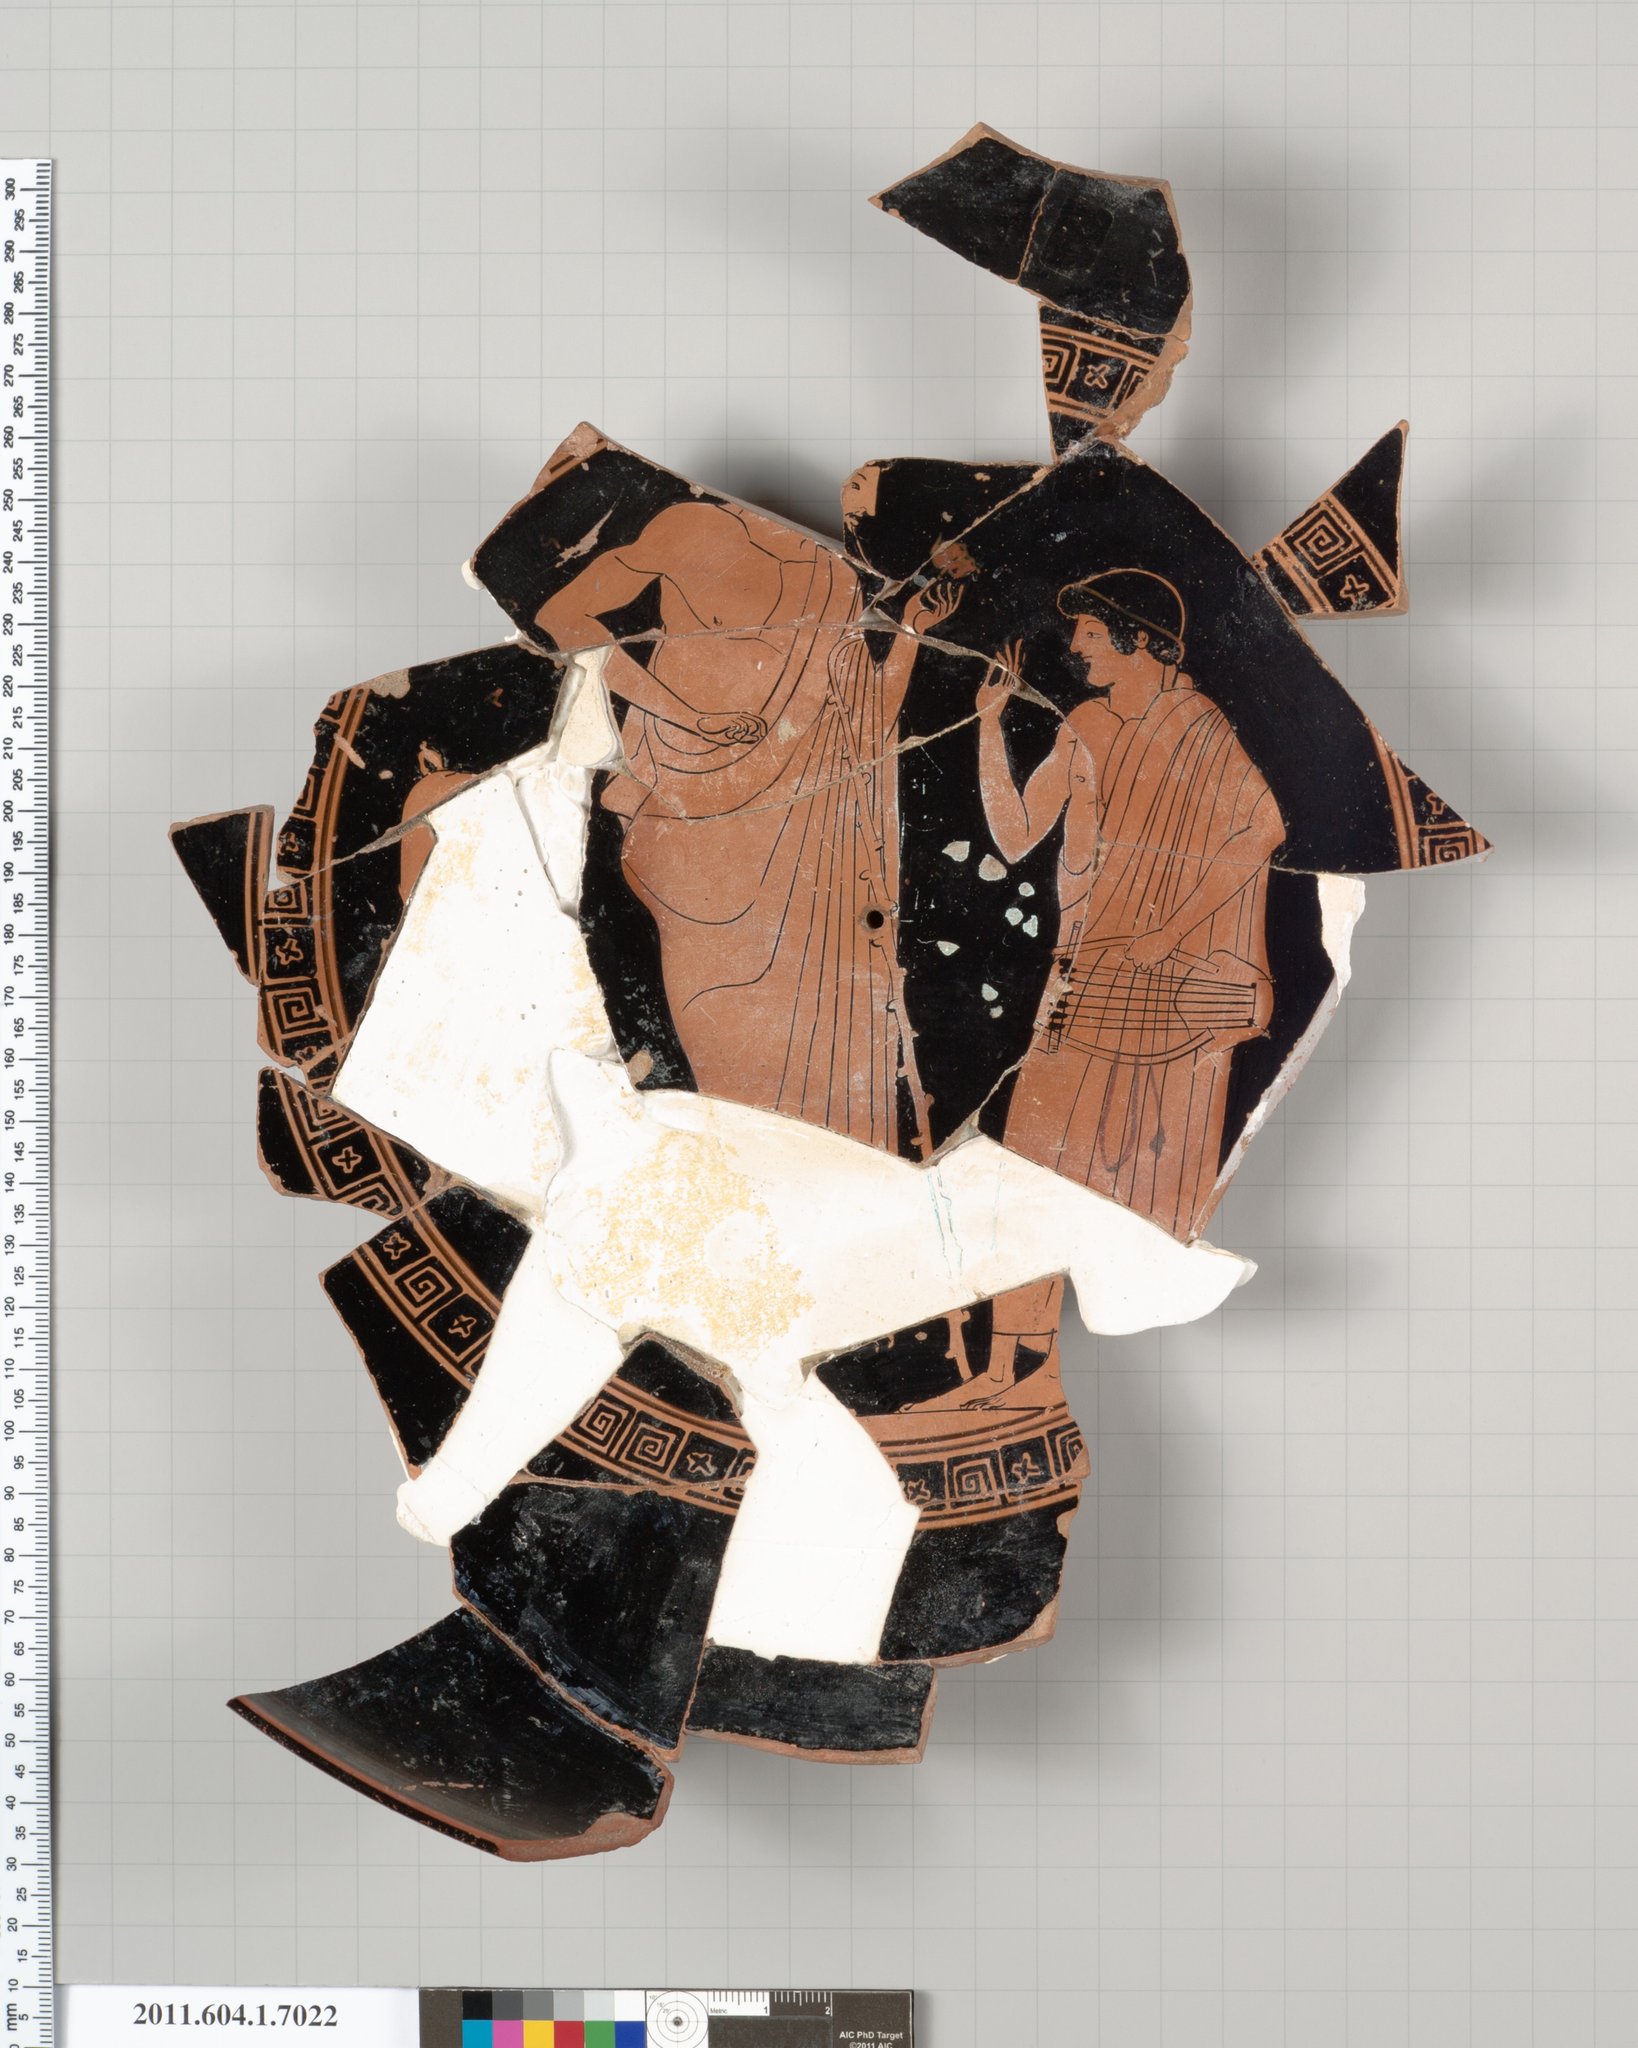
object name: kylix fragment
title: Terracotta fragment of a kylix (drinking cup)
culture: greek, attic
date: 500-480 BCE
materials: terracotta